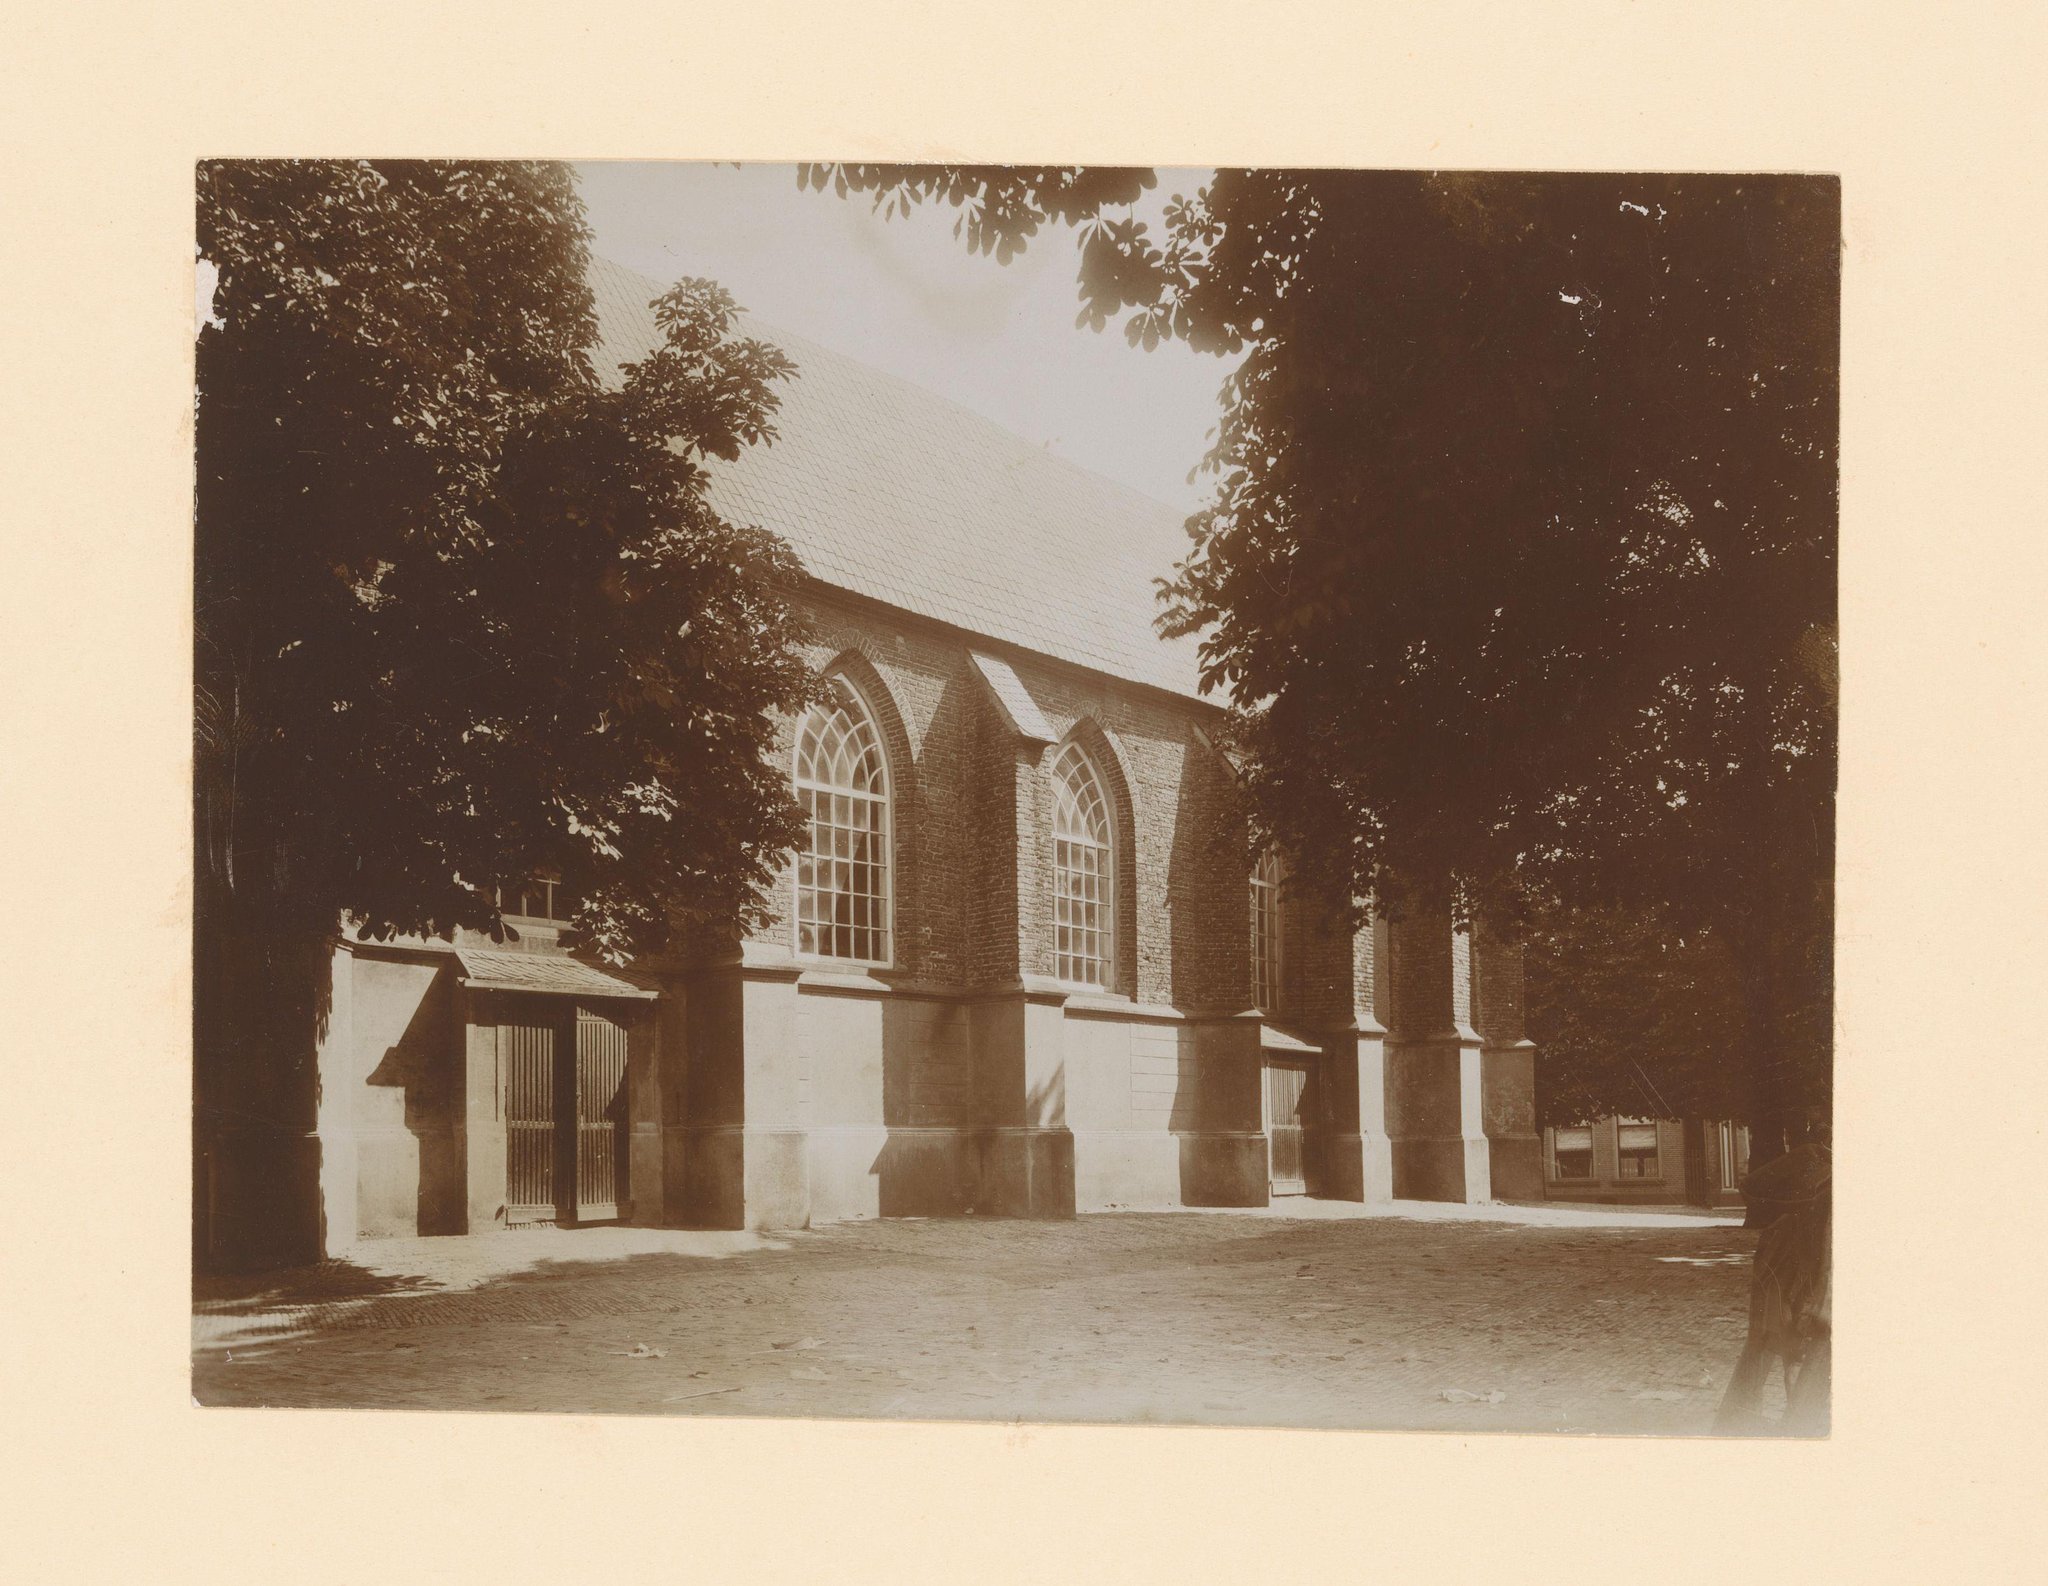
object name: photograph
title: Gedeelte van de Nicolaaskerk te Wijhe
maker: anoniem (monumentenzorg)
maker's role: fotograaf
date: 1911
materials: cardboard, photographic support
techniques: collodion silver print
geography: wijhe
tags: church (exterior)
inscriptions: annotation: ‘Wijhe’, annotation: ‘Ned. Herv. kerk te Wijhe aug 1911’